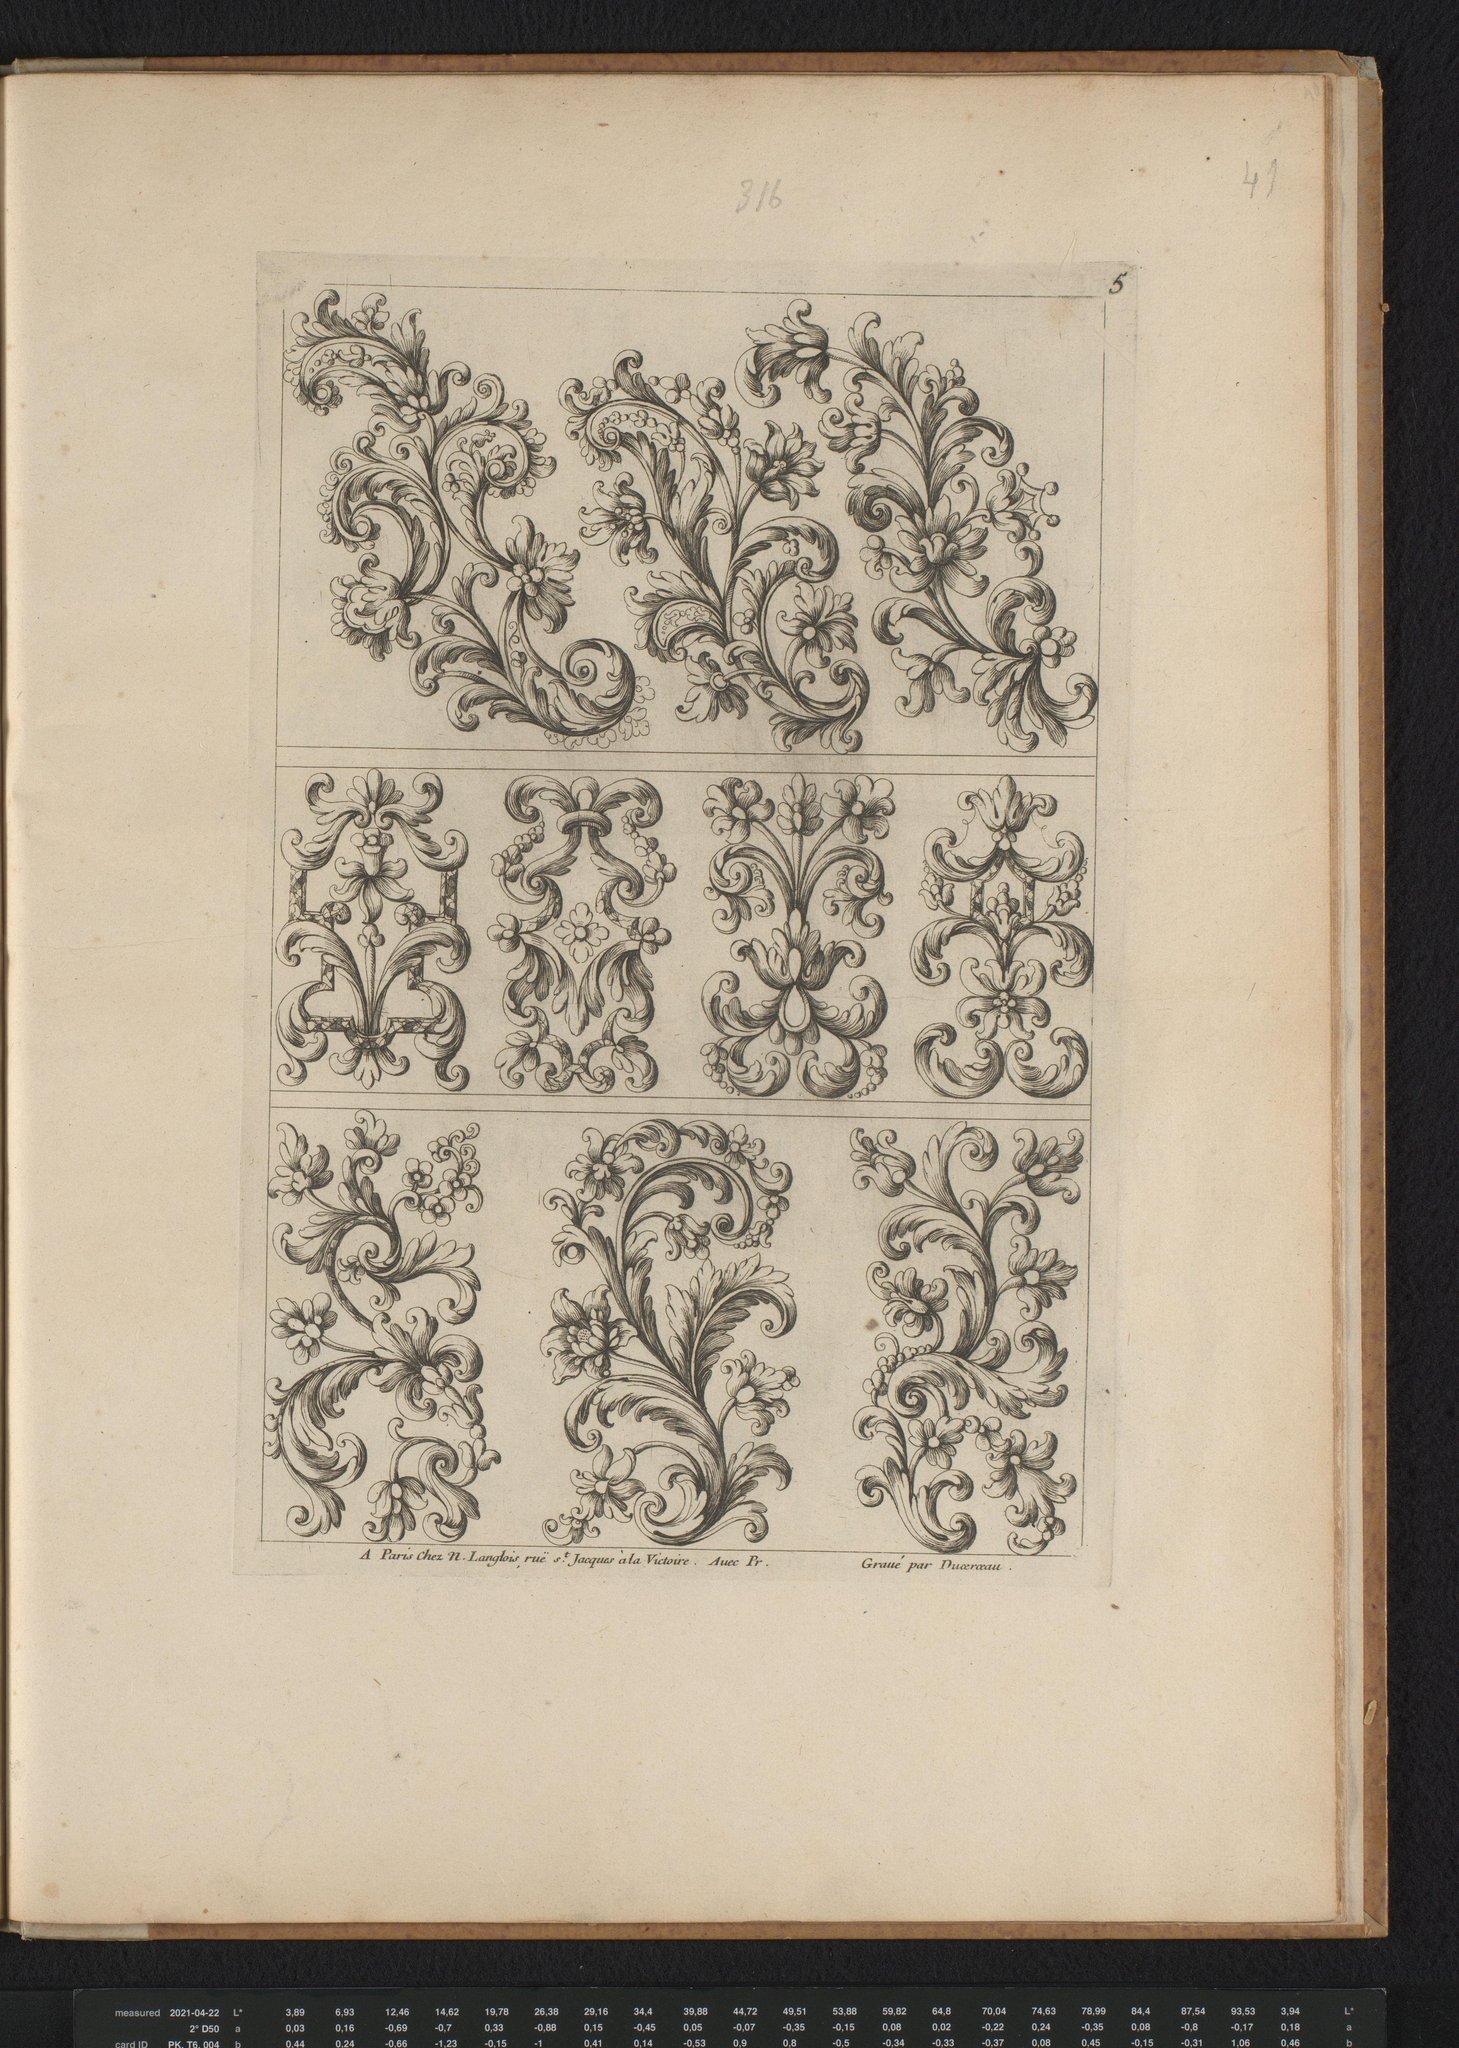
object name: album leaf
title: Ontwerpen voor borduurwerk op mannenkleding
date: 1670-1690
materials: paper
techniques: etching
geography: france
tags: foliage, tendrils, branches ~ ornament, embroidery (ornamentation)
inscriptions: collector's mark: Lugt 2760, collector's mark: Lugt 2228a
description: Deze prent maakt deel uit van een album.